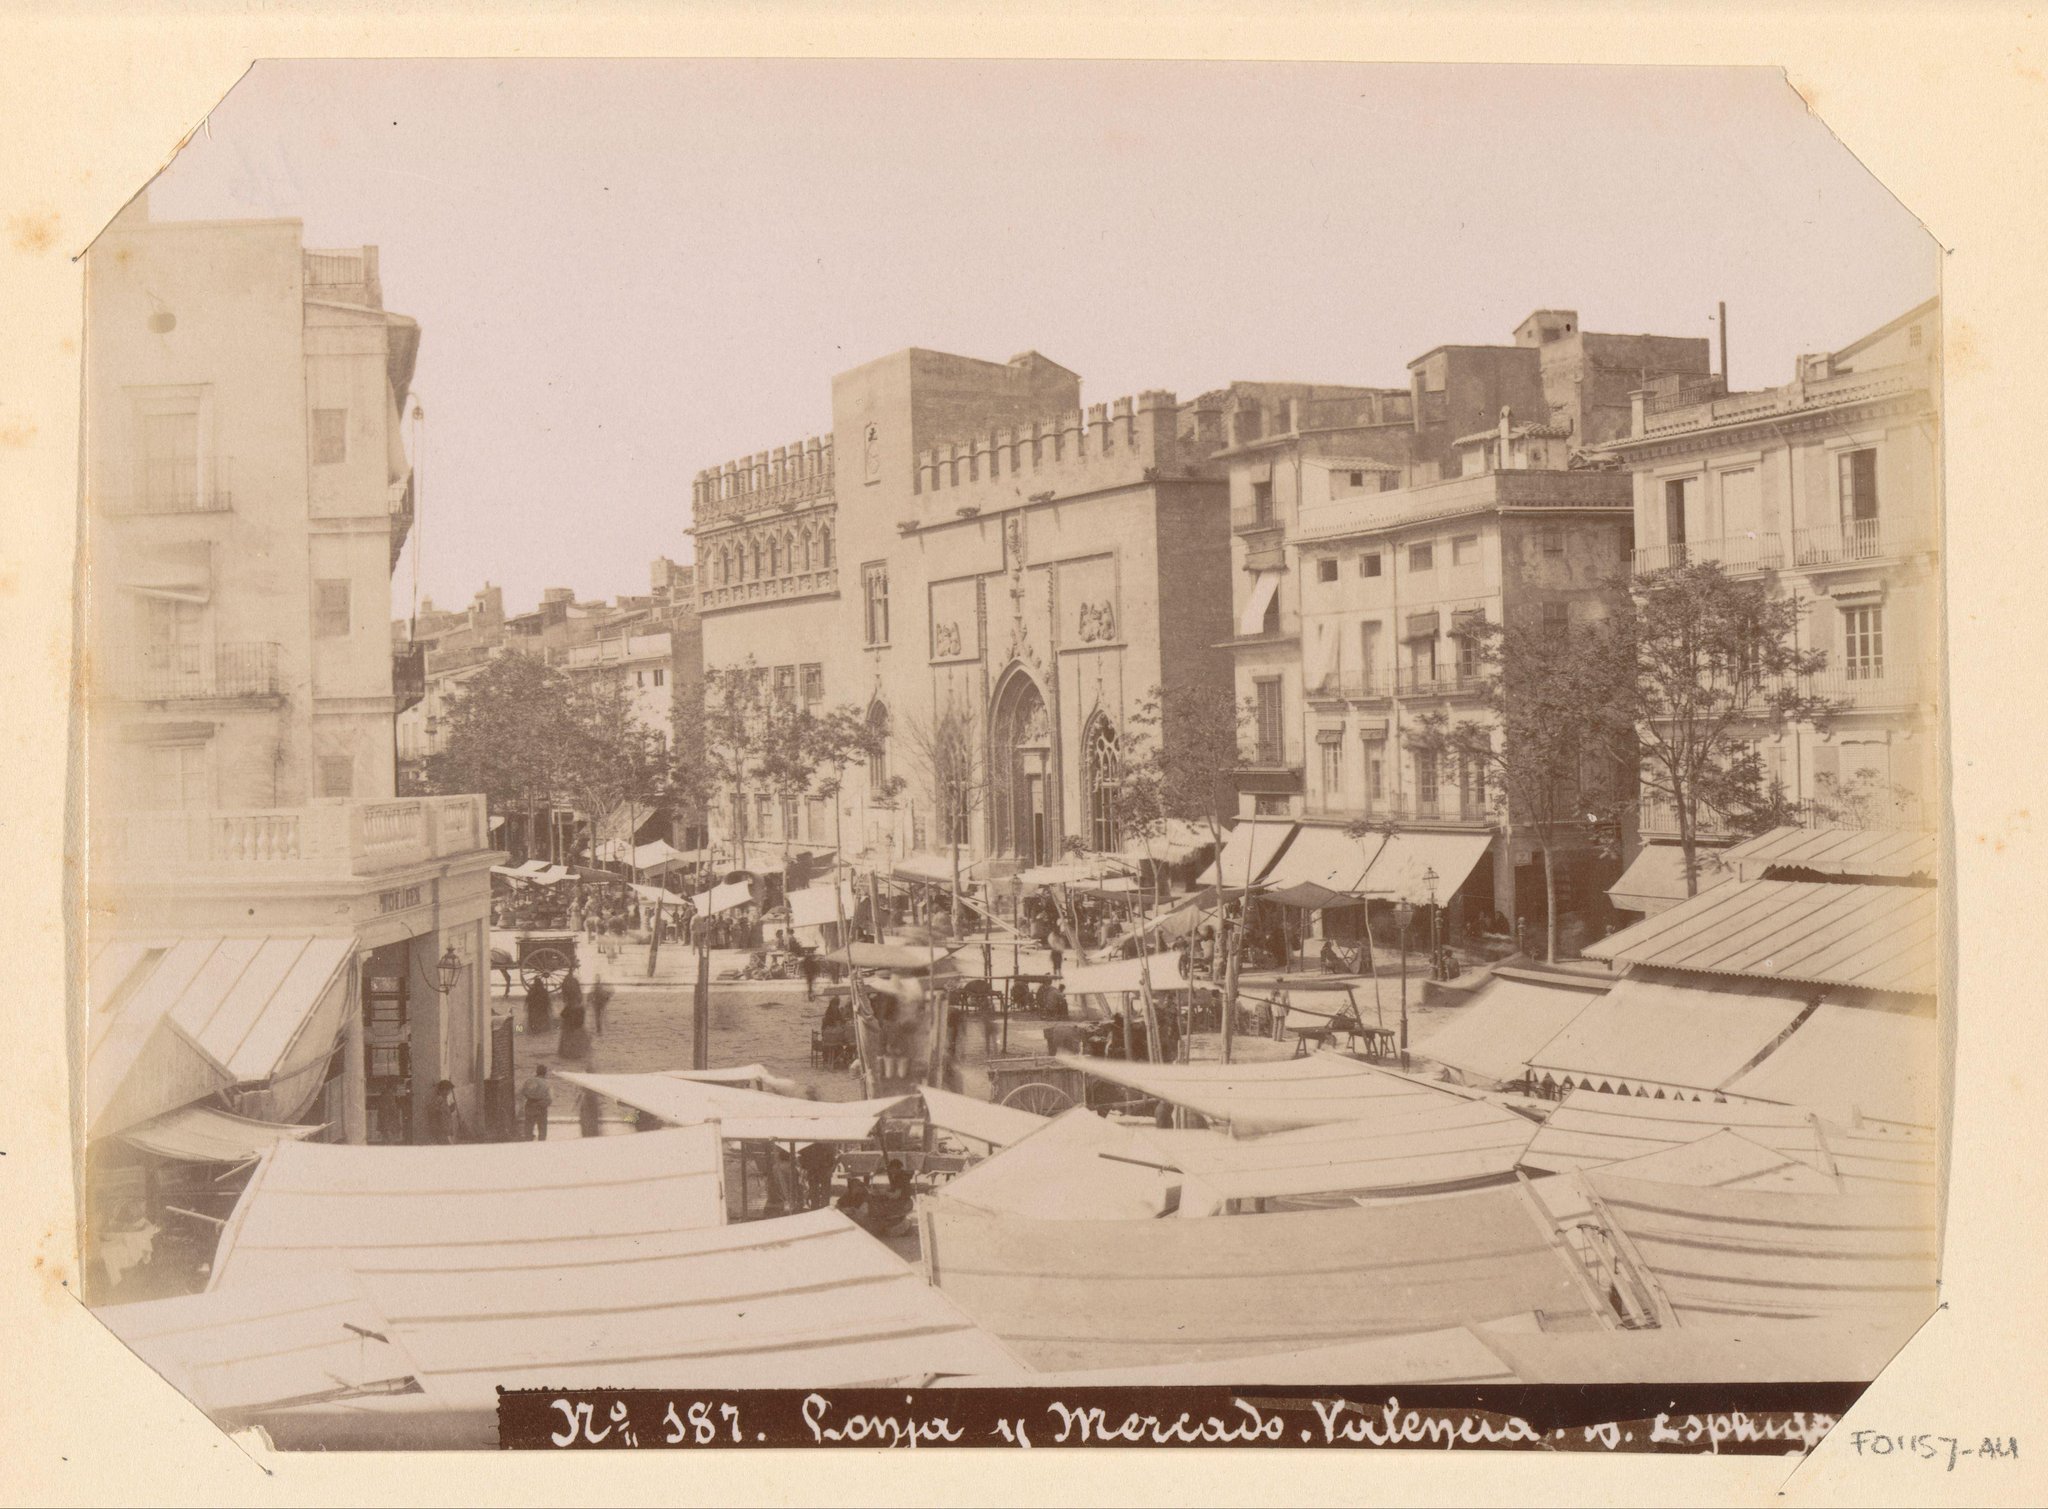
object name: photograph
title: Markt te Valencia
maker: antoni esplugas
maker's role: fotograaf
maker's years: 1852-1929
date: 1888-1892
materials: photographic support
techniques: albumen print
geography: valencia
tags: market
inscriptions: number: ‘187’, annotation: ‘Valencia - Marktplaats en Plaza de Toros’